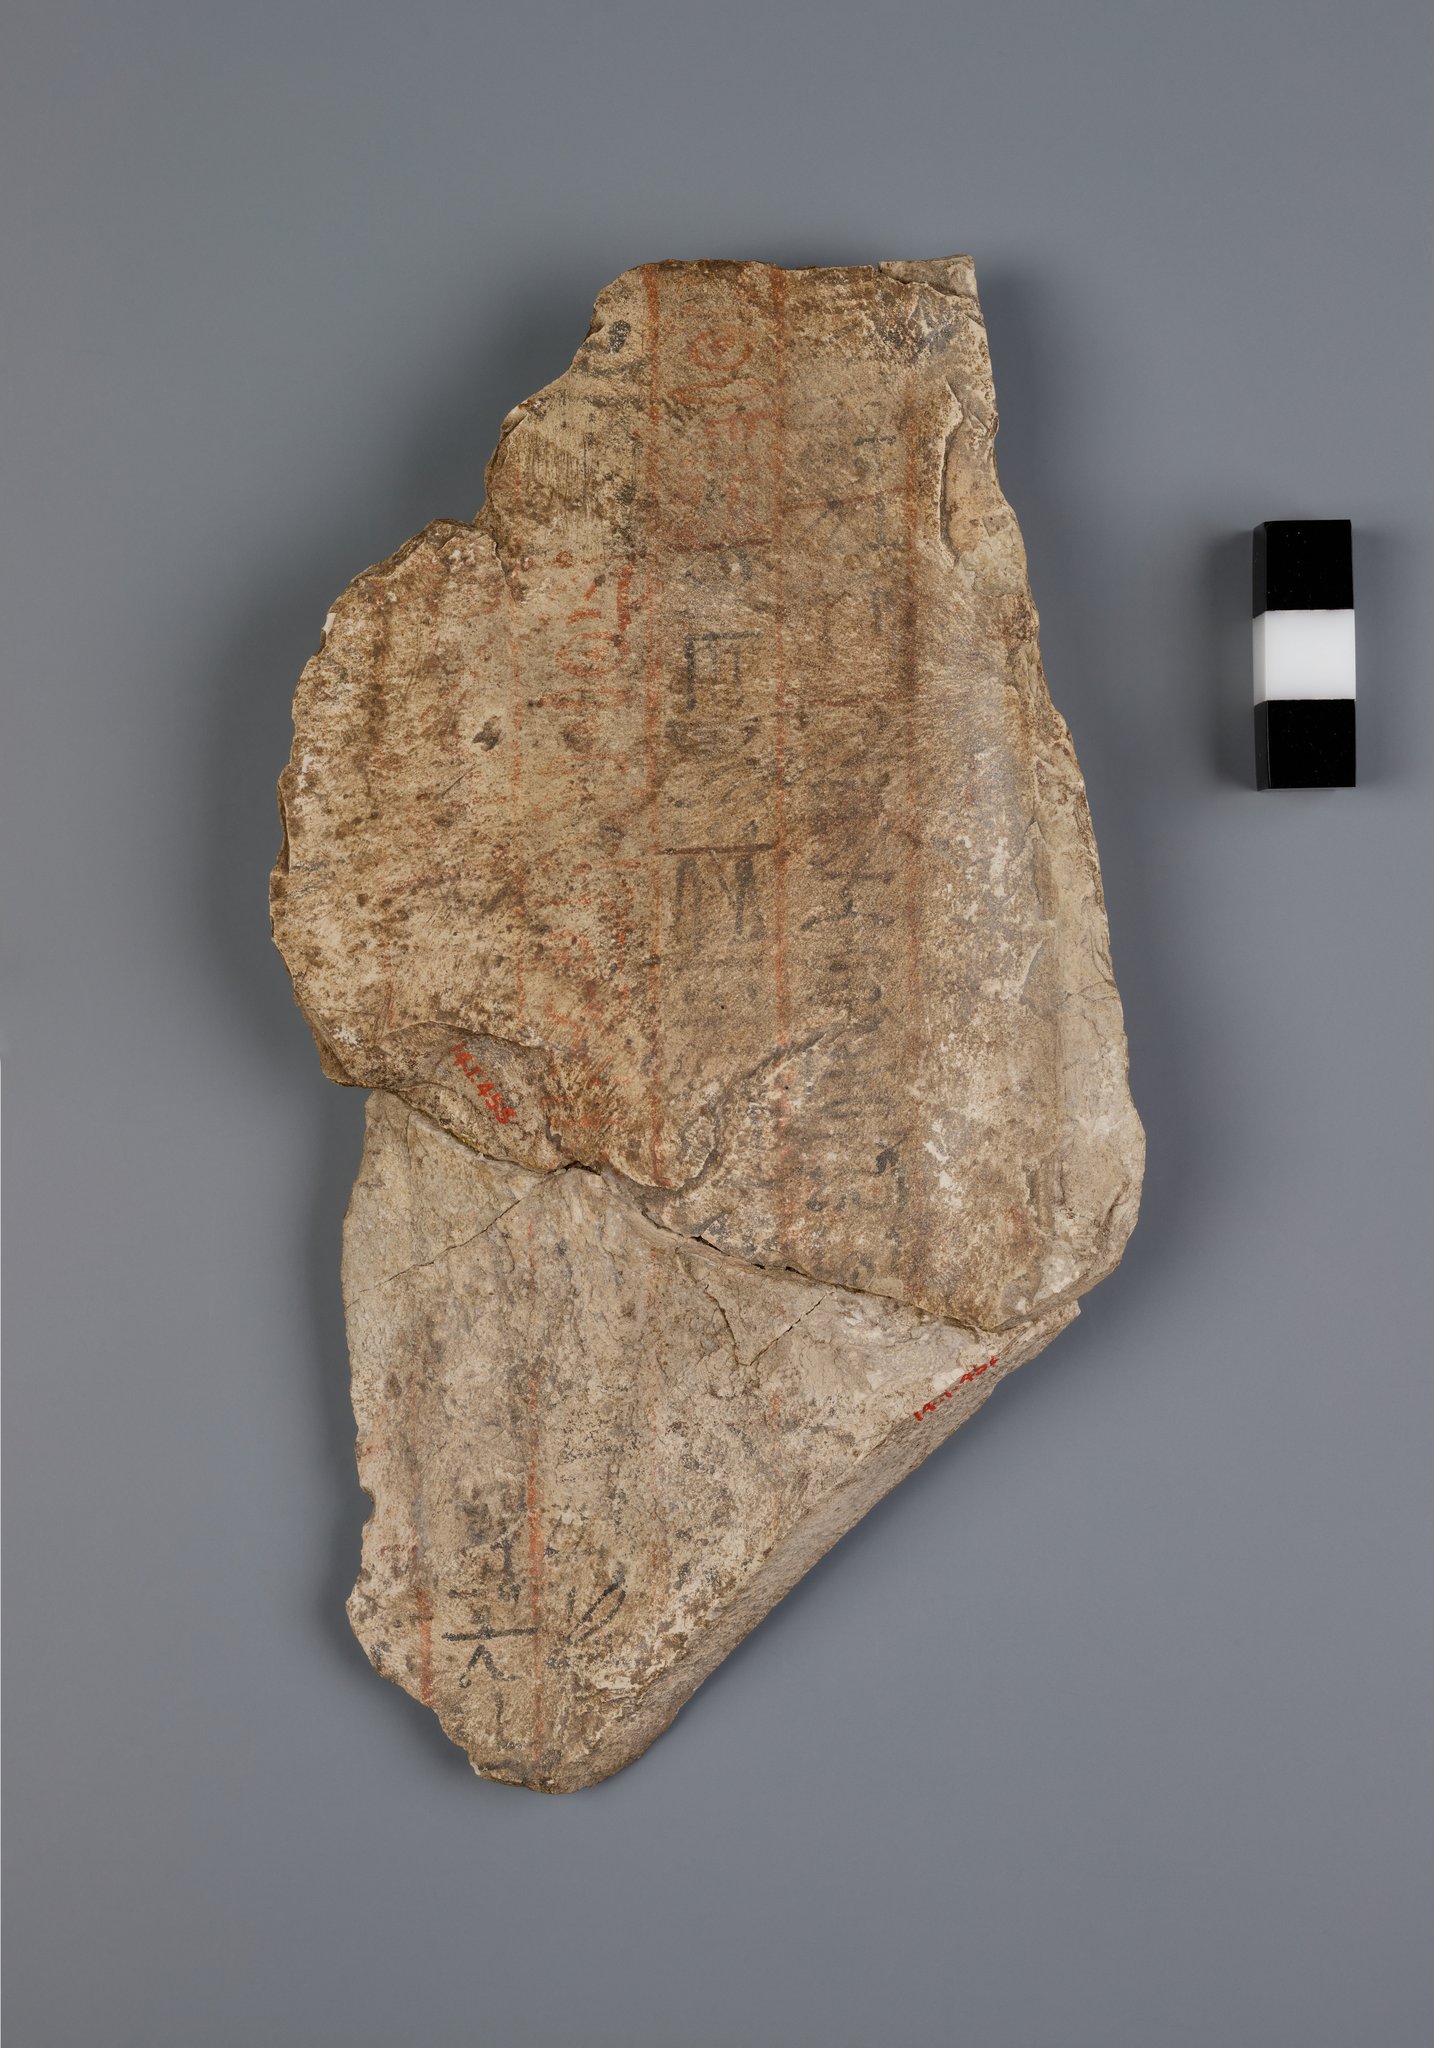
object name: ostracon, cursive hieroglyphic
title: Hieratic ostracon with practice layout for monumental inscription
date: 1550-1070 BCE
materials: limestone, paint